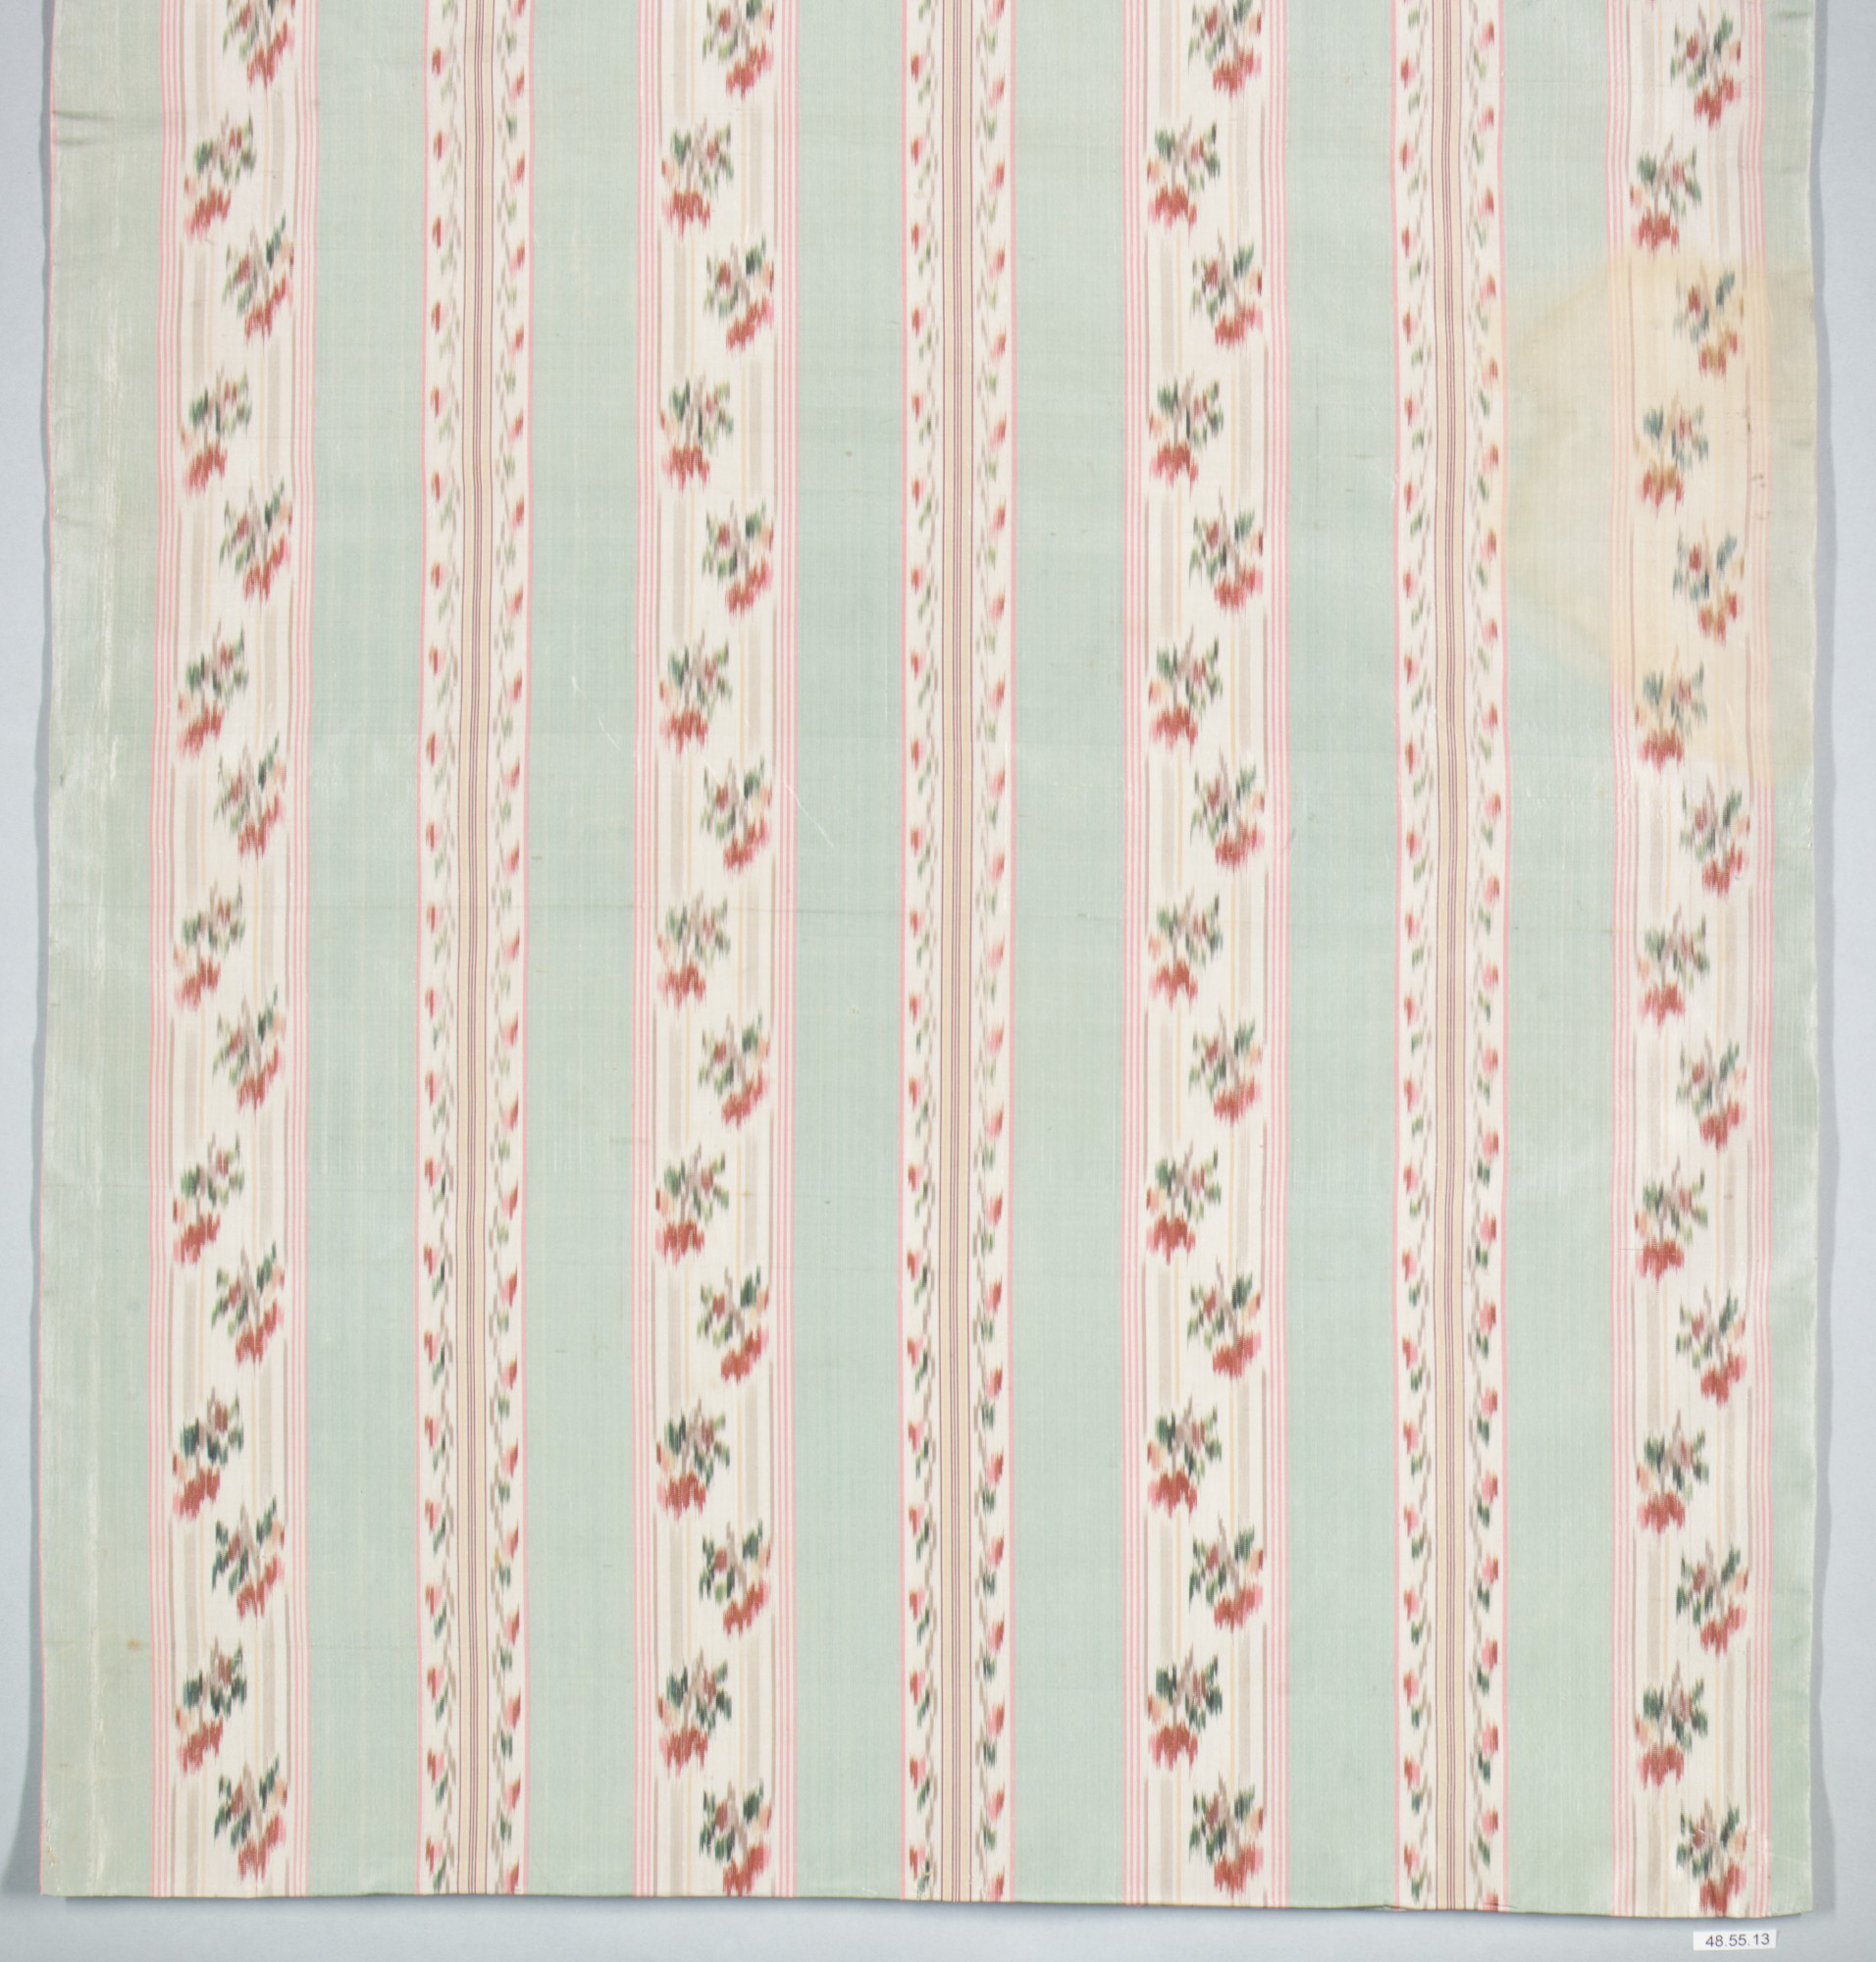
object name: piece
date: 1770-1780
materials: silk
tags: flowers